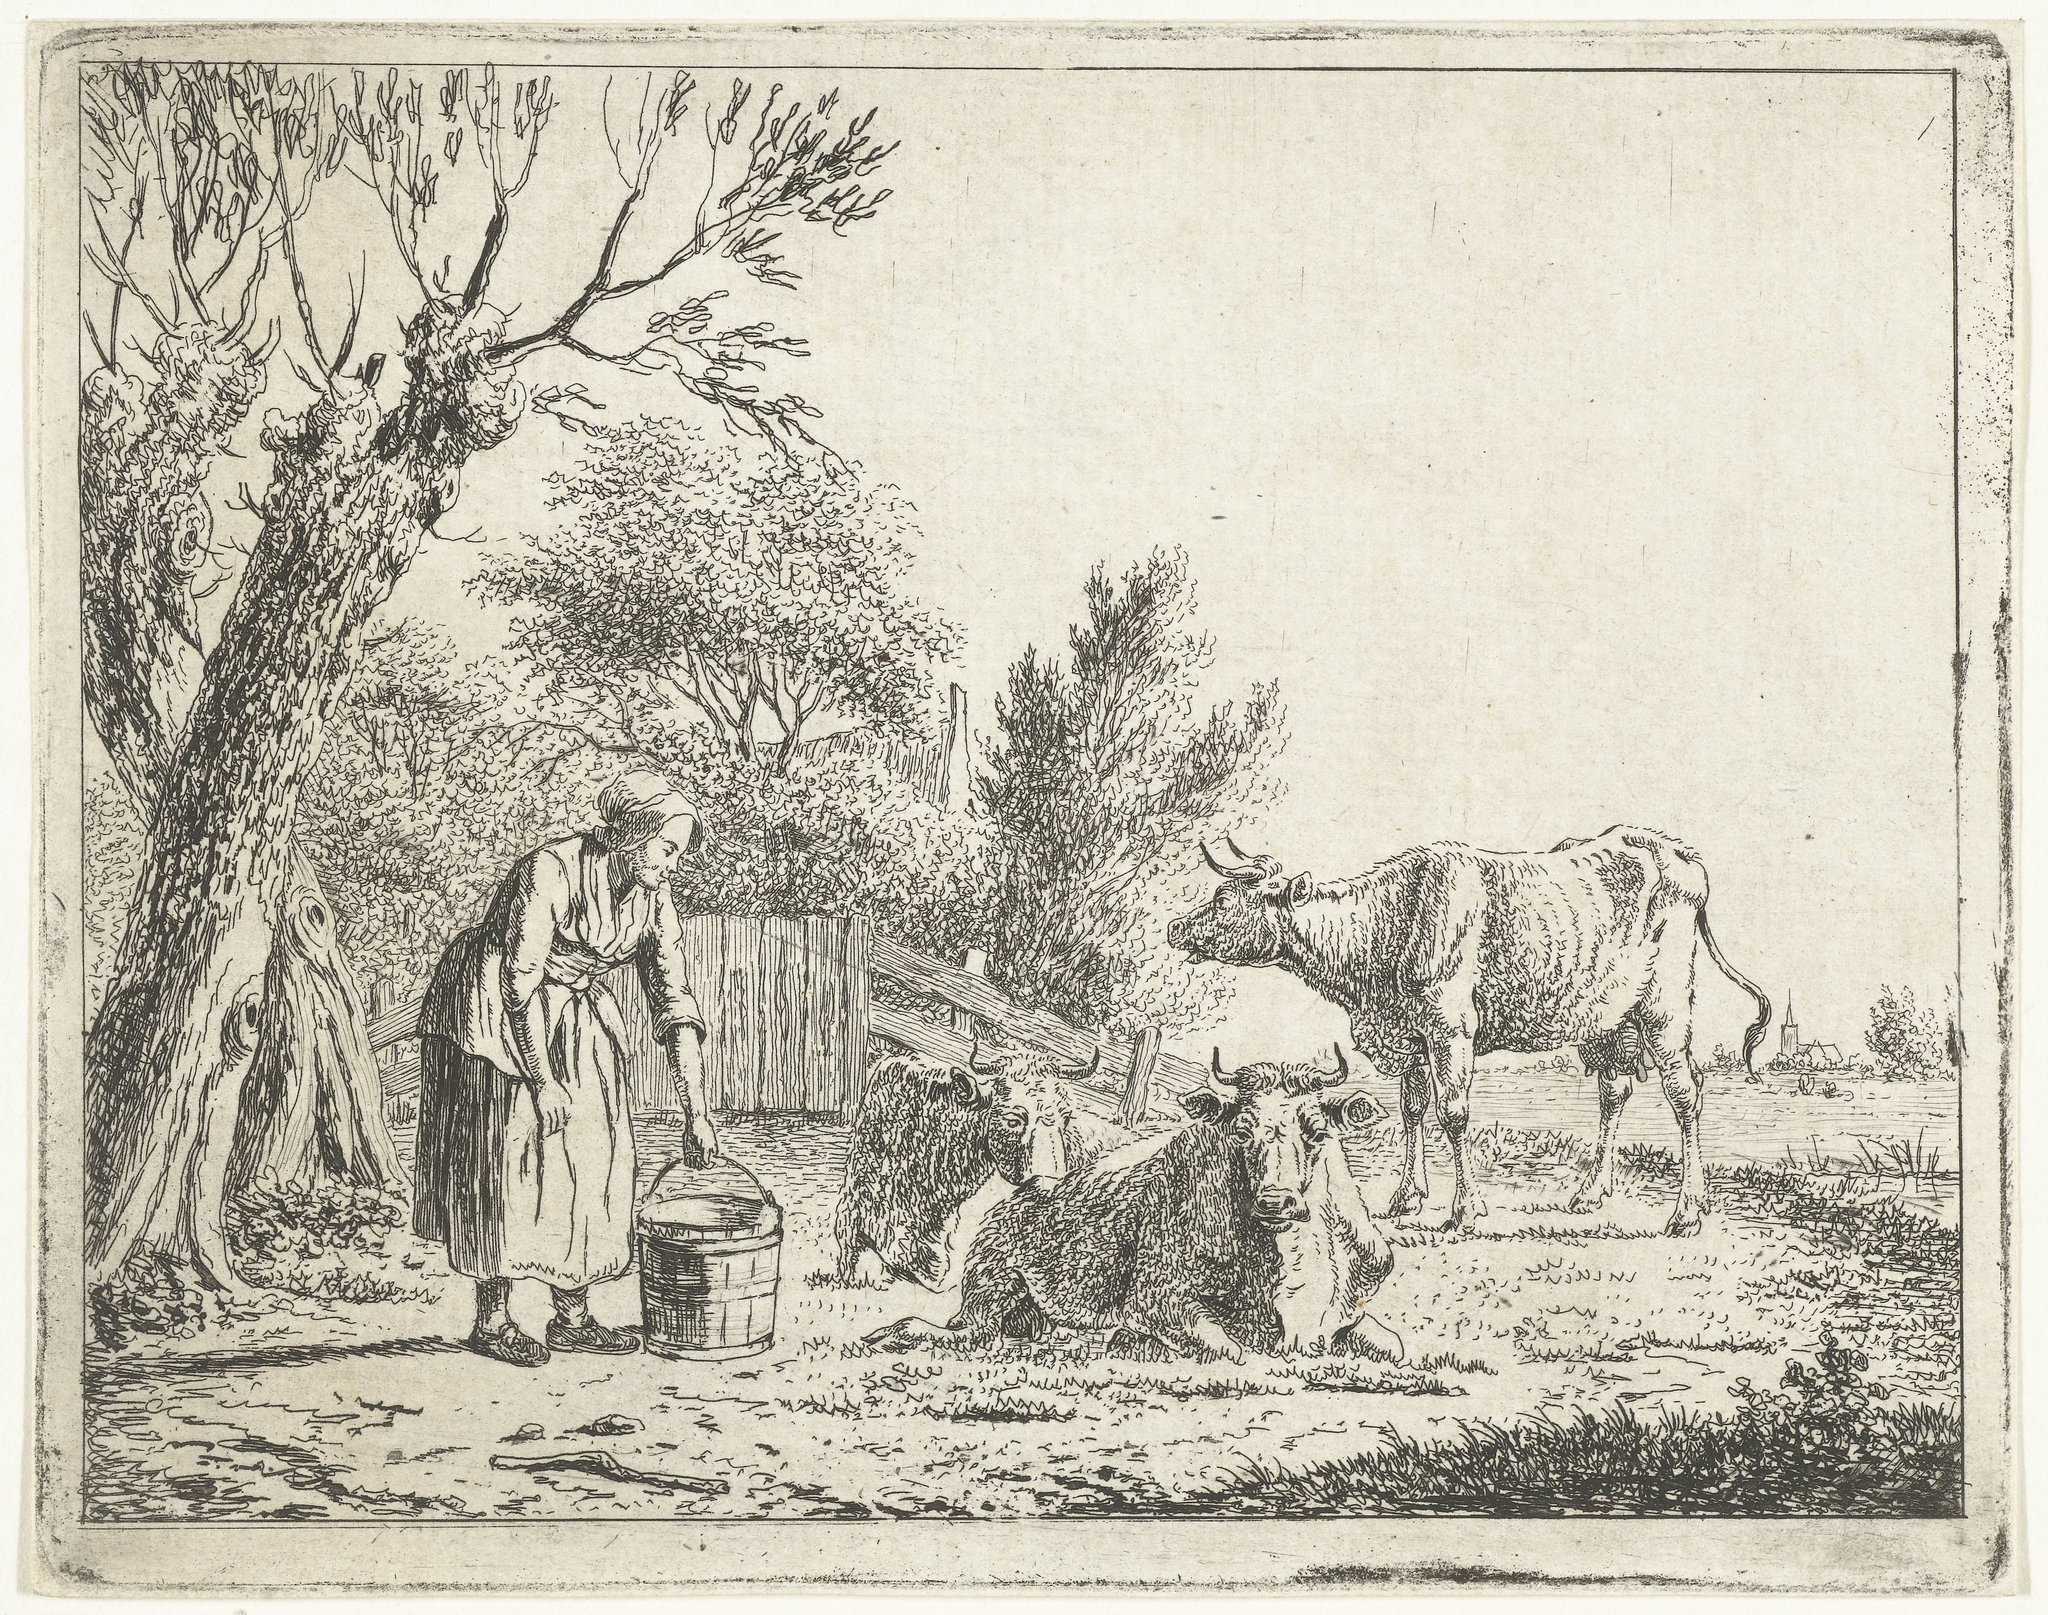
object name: print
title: Landschap met vrouw met melkemmer en drie koeien bij boerderij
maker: cornelis bisschop (1762-1829)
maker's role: print maker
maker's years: 1762-1829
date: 1777-1829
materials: paper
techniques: etching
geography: netherlands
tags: wooden container: barrel, cask, bucket, cow, milkmaid, farm or solitary house in landscape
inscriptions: collector's mark: Lugt 698, collector's mark: Lugt 2228